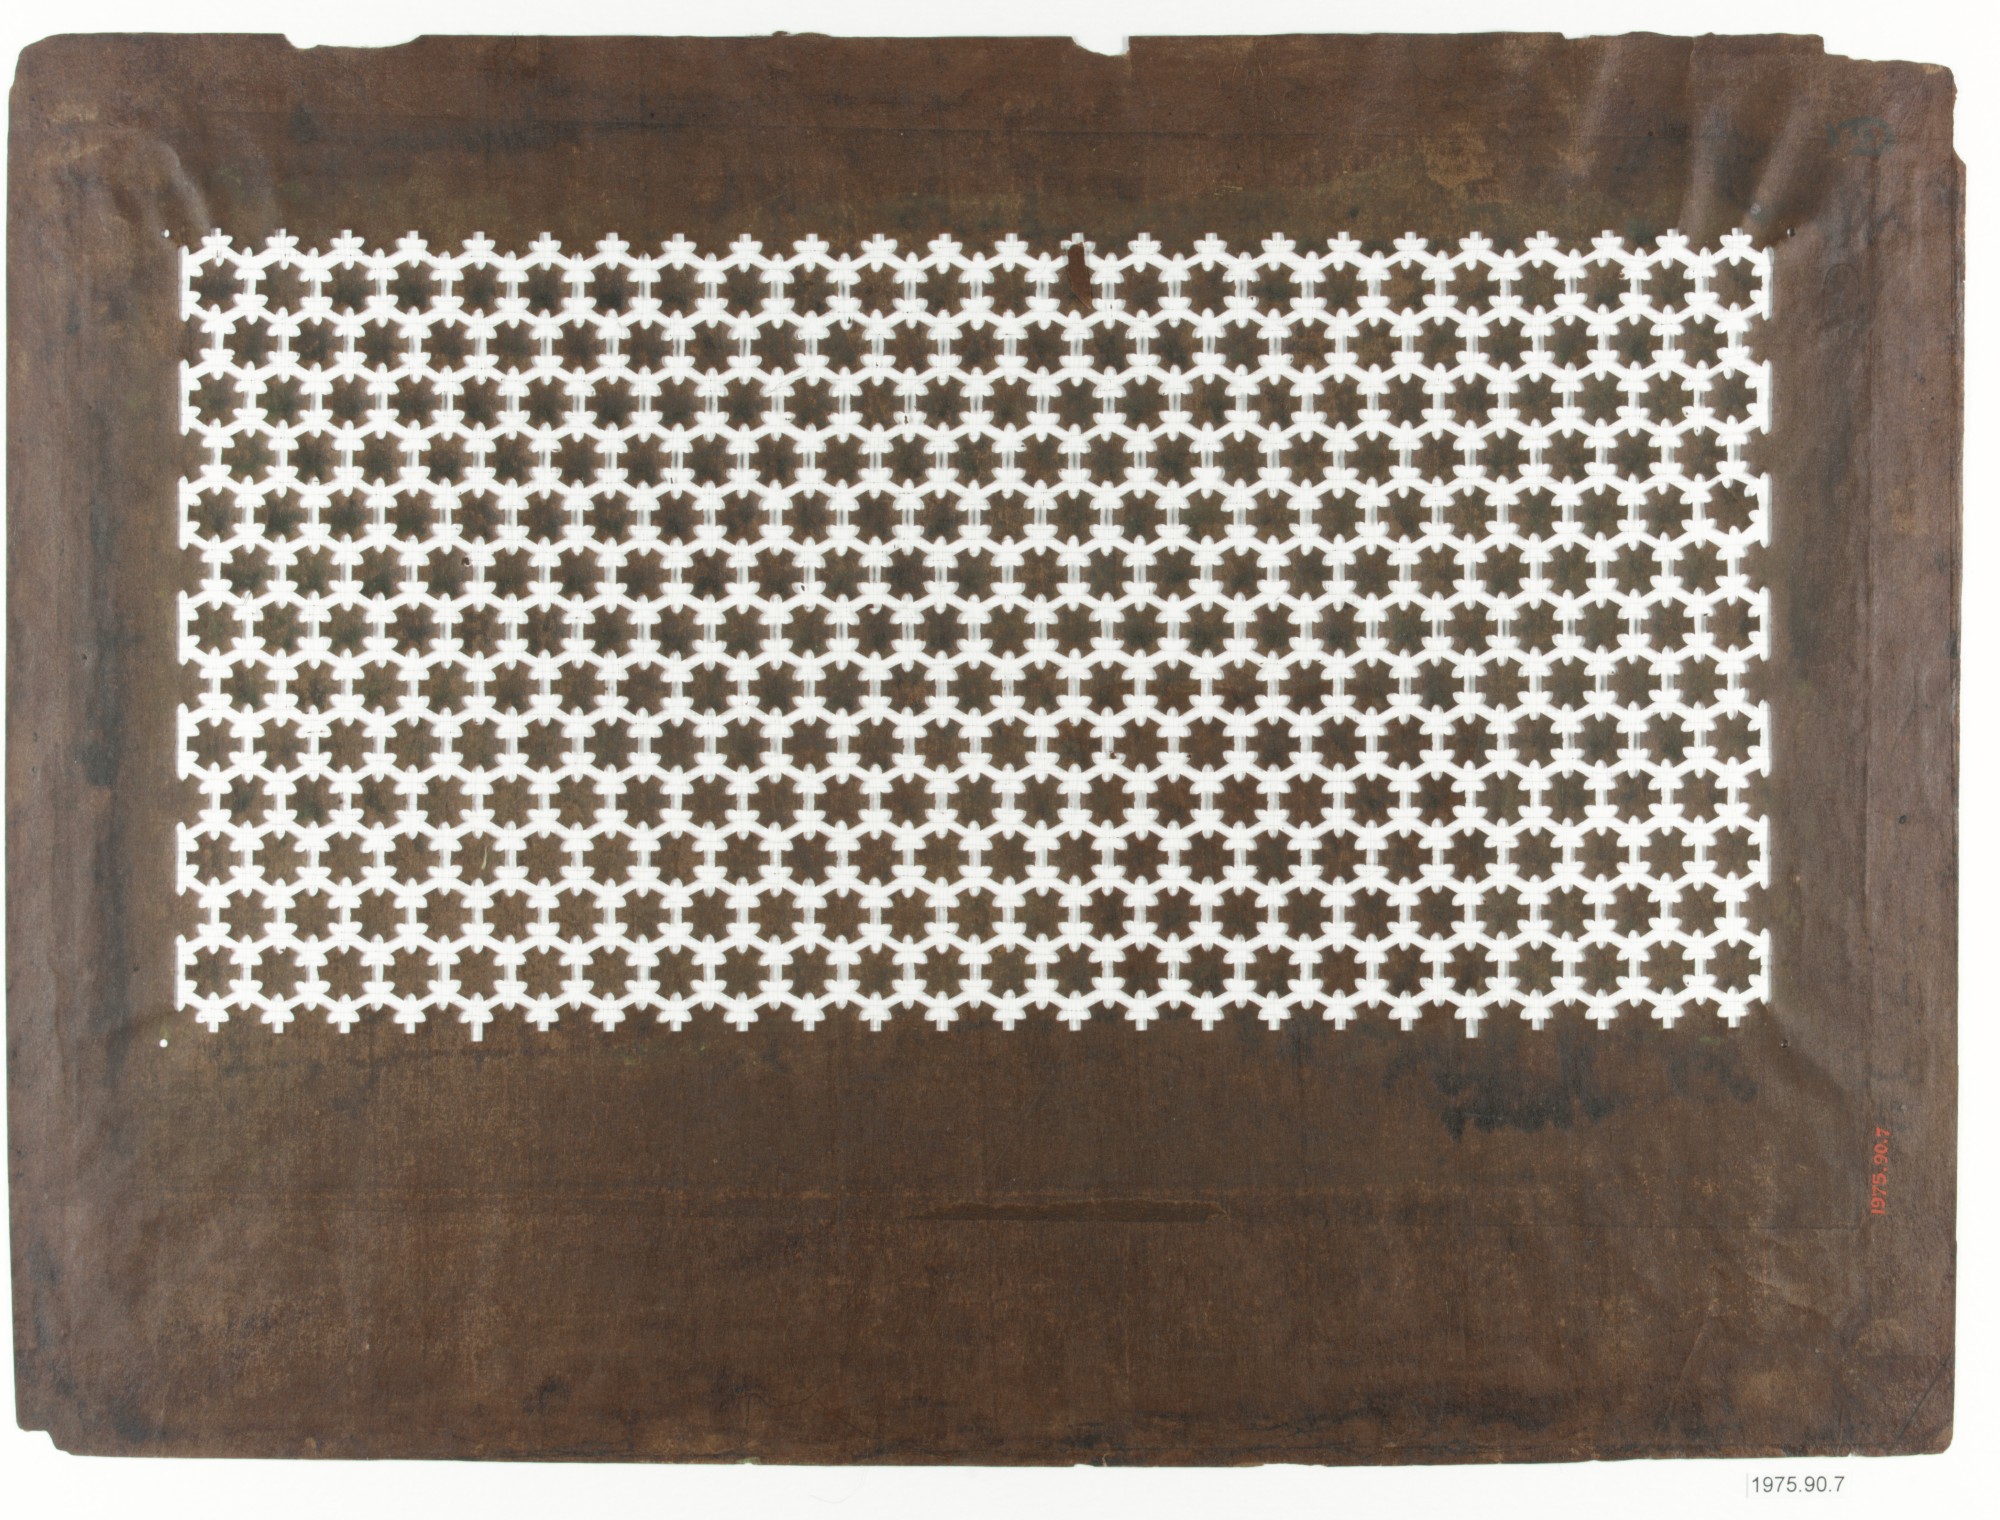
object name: stencil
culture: japanese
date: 1867-1933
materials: paper, silk